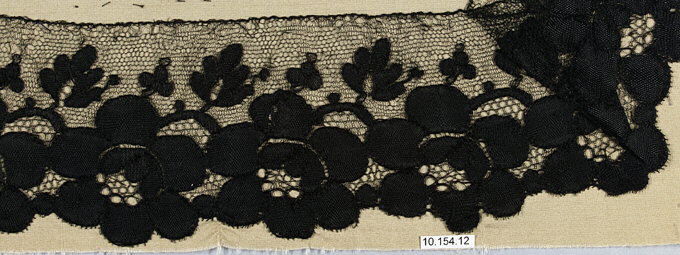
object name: piece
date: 1801-1900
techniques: lace